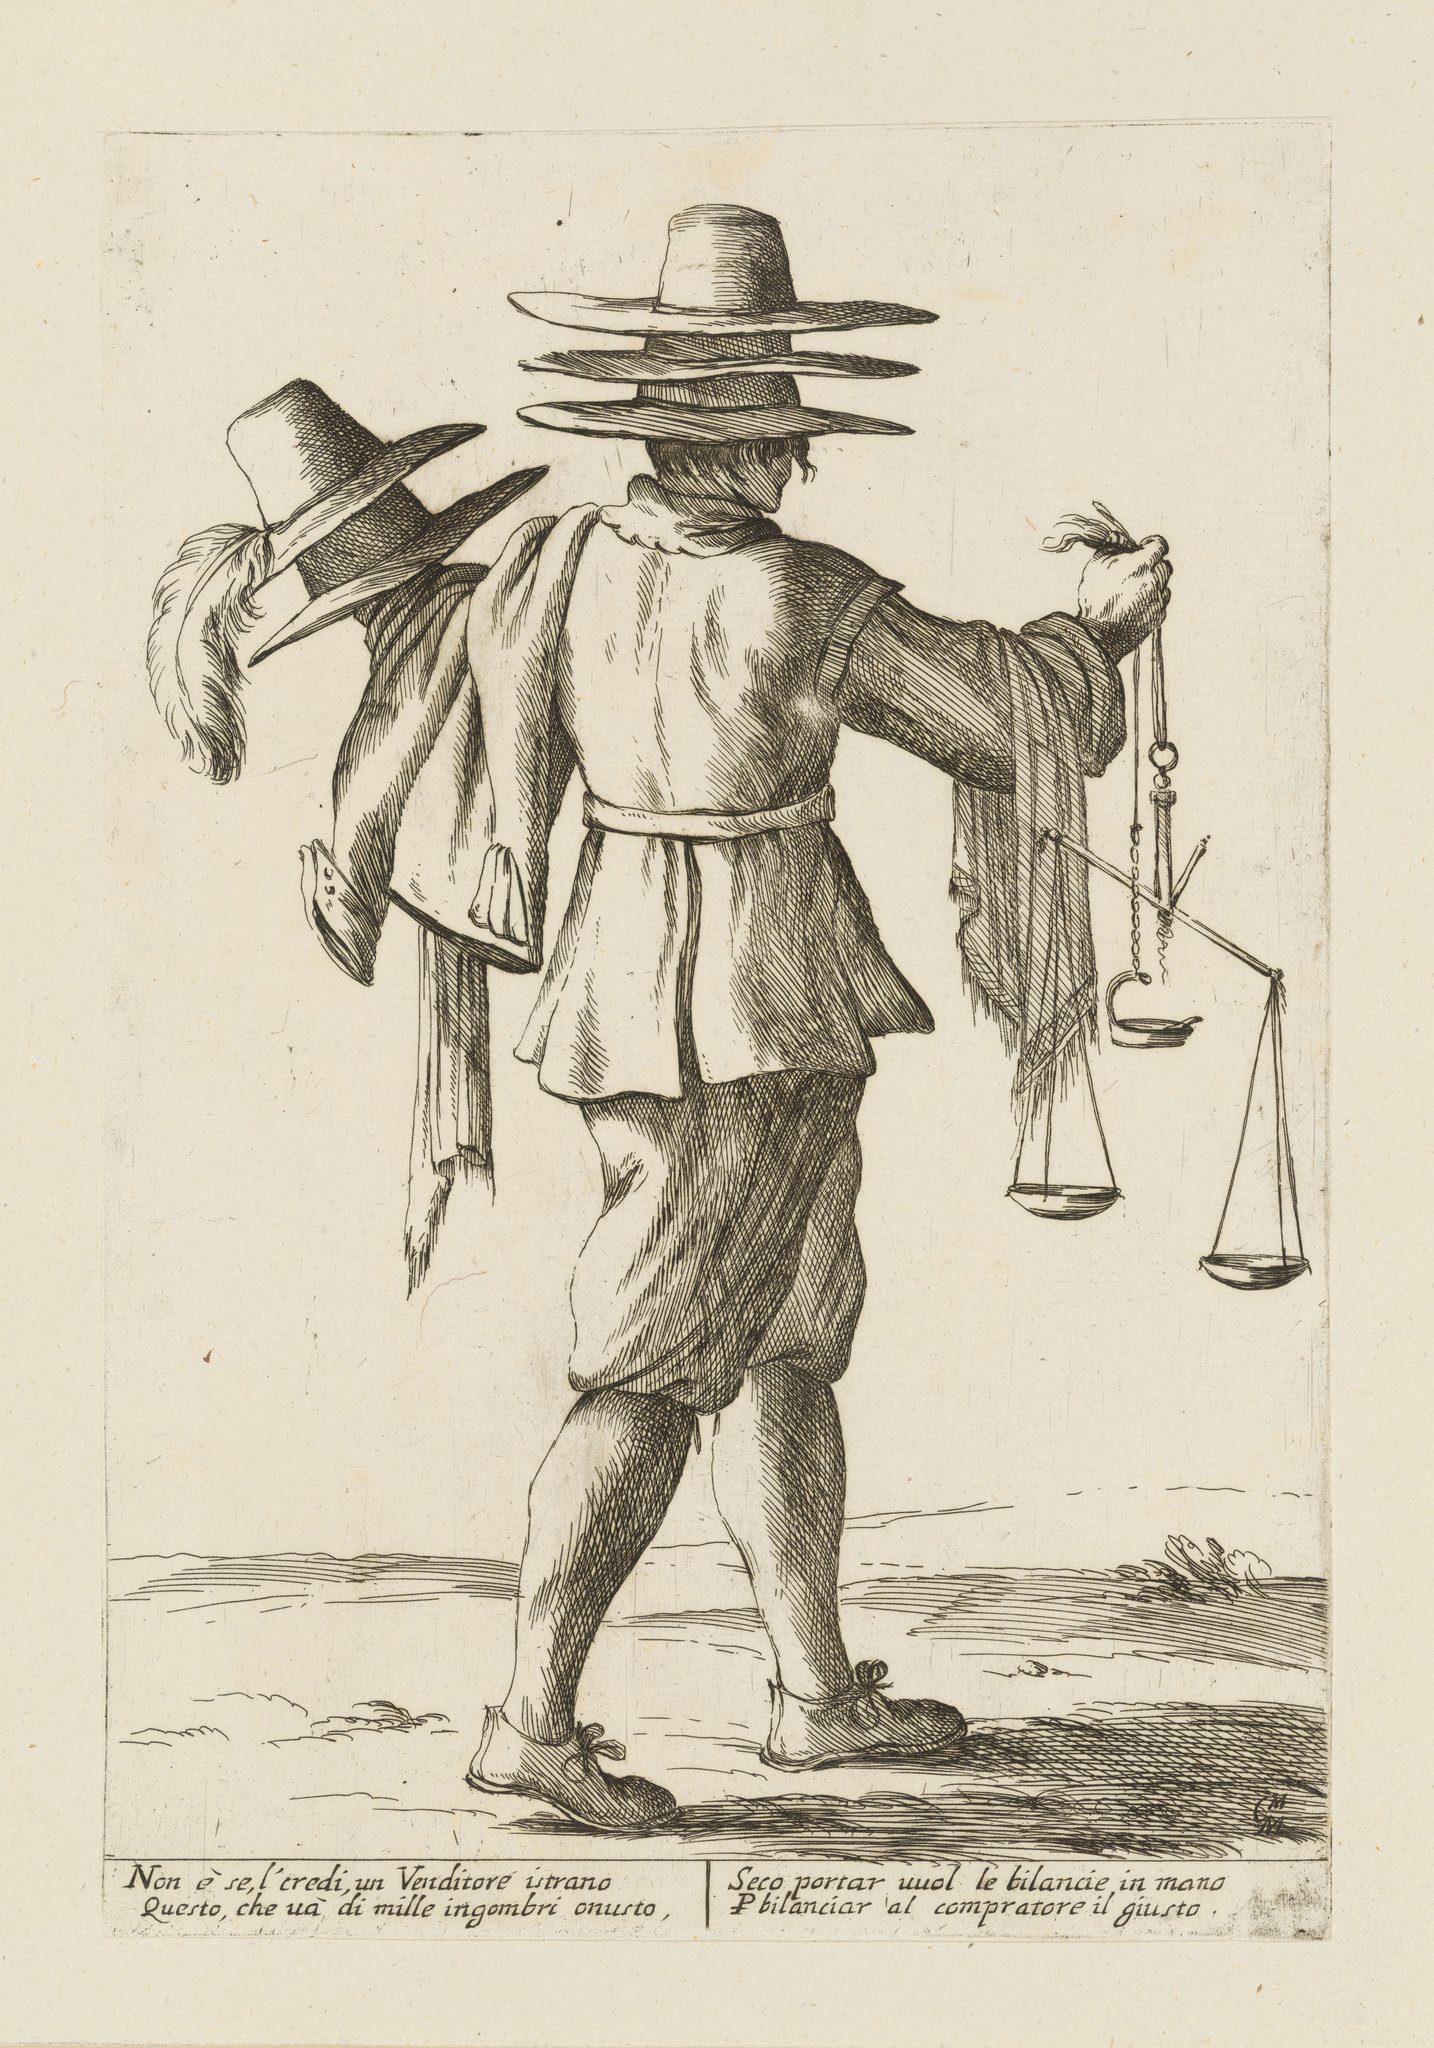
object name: print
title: Hat Vendor, from Di Bologna l'Arti per via D'An.ibal' Ca.rac, plate 33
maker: giuseppe maria mitelli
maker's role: artist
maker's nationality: italian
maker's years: 1634-1718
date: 1660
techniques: etching